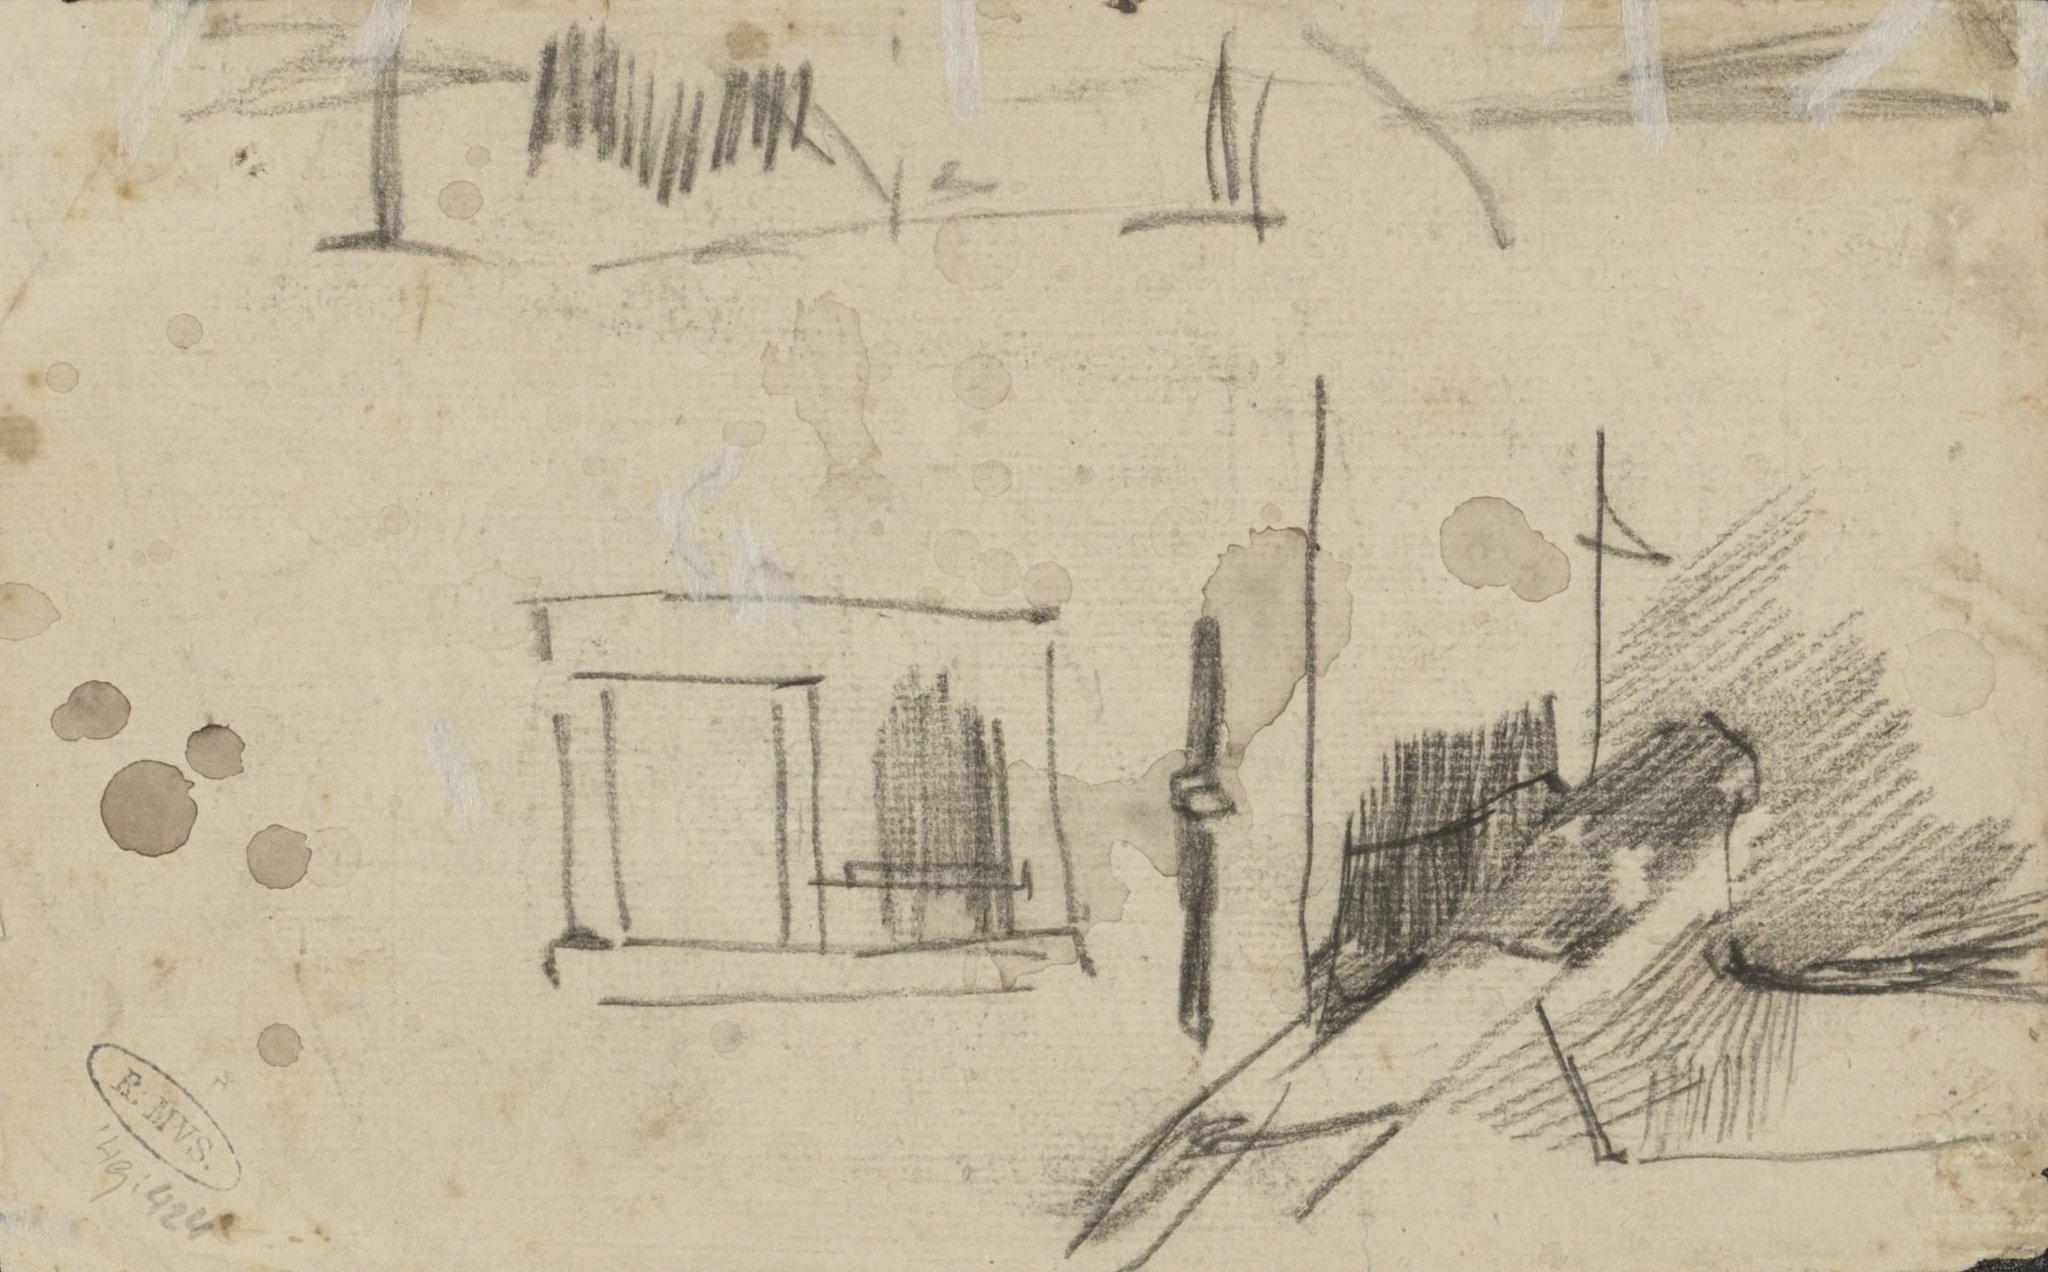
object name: drawing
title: Gevel met een raam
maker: george hendrik breitner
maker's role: draughtsman, painter, print maker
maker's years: 1857-1923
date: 1898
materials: chalk, paper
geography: amsterdam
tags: urban housing, façade (of house or building)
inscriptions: collector's mark: Lugt 2228